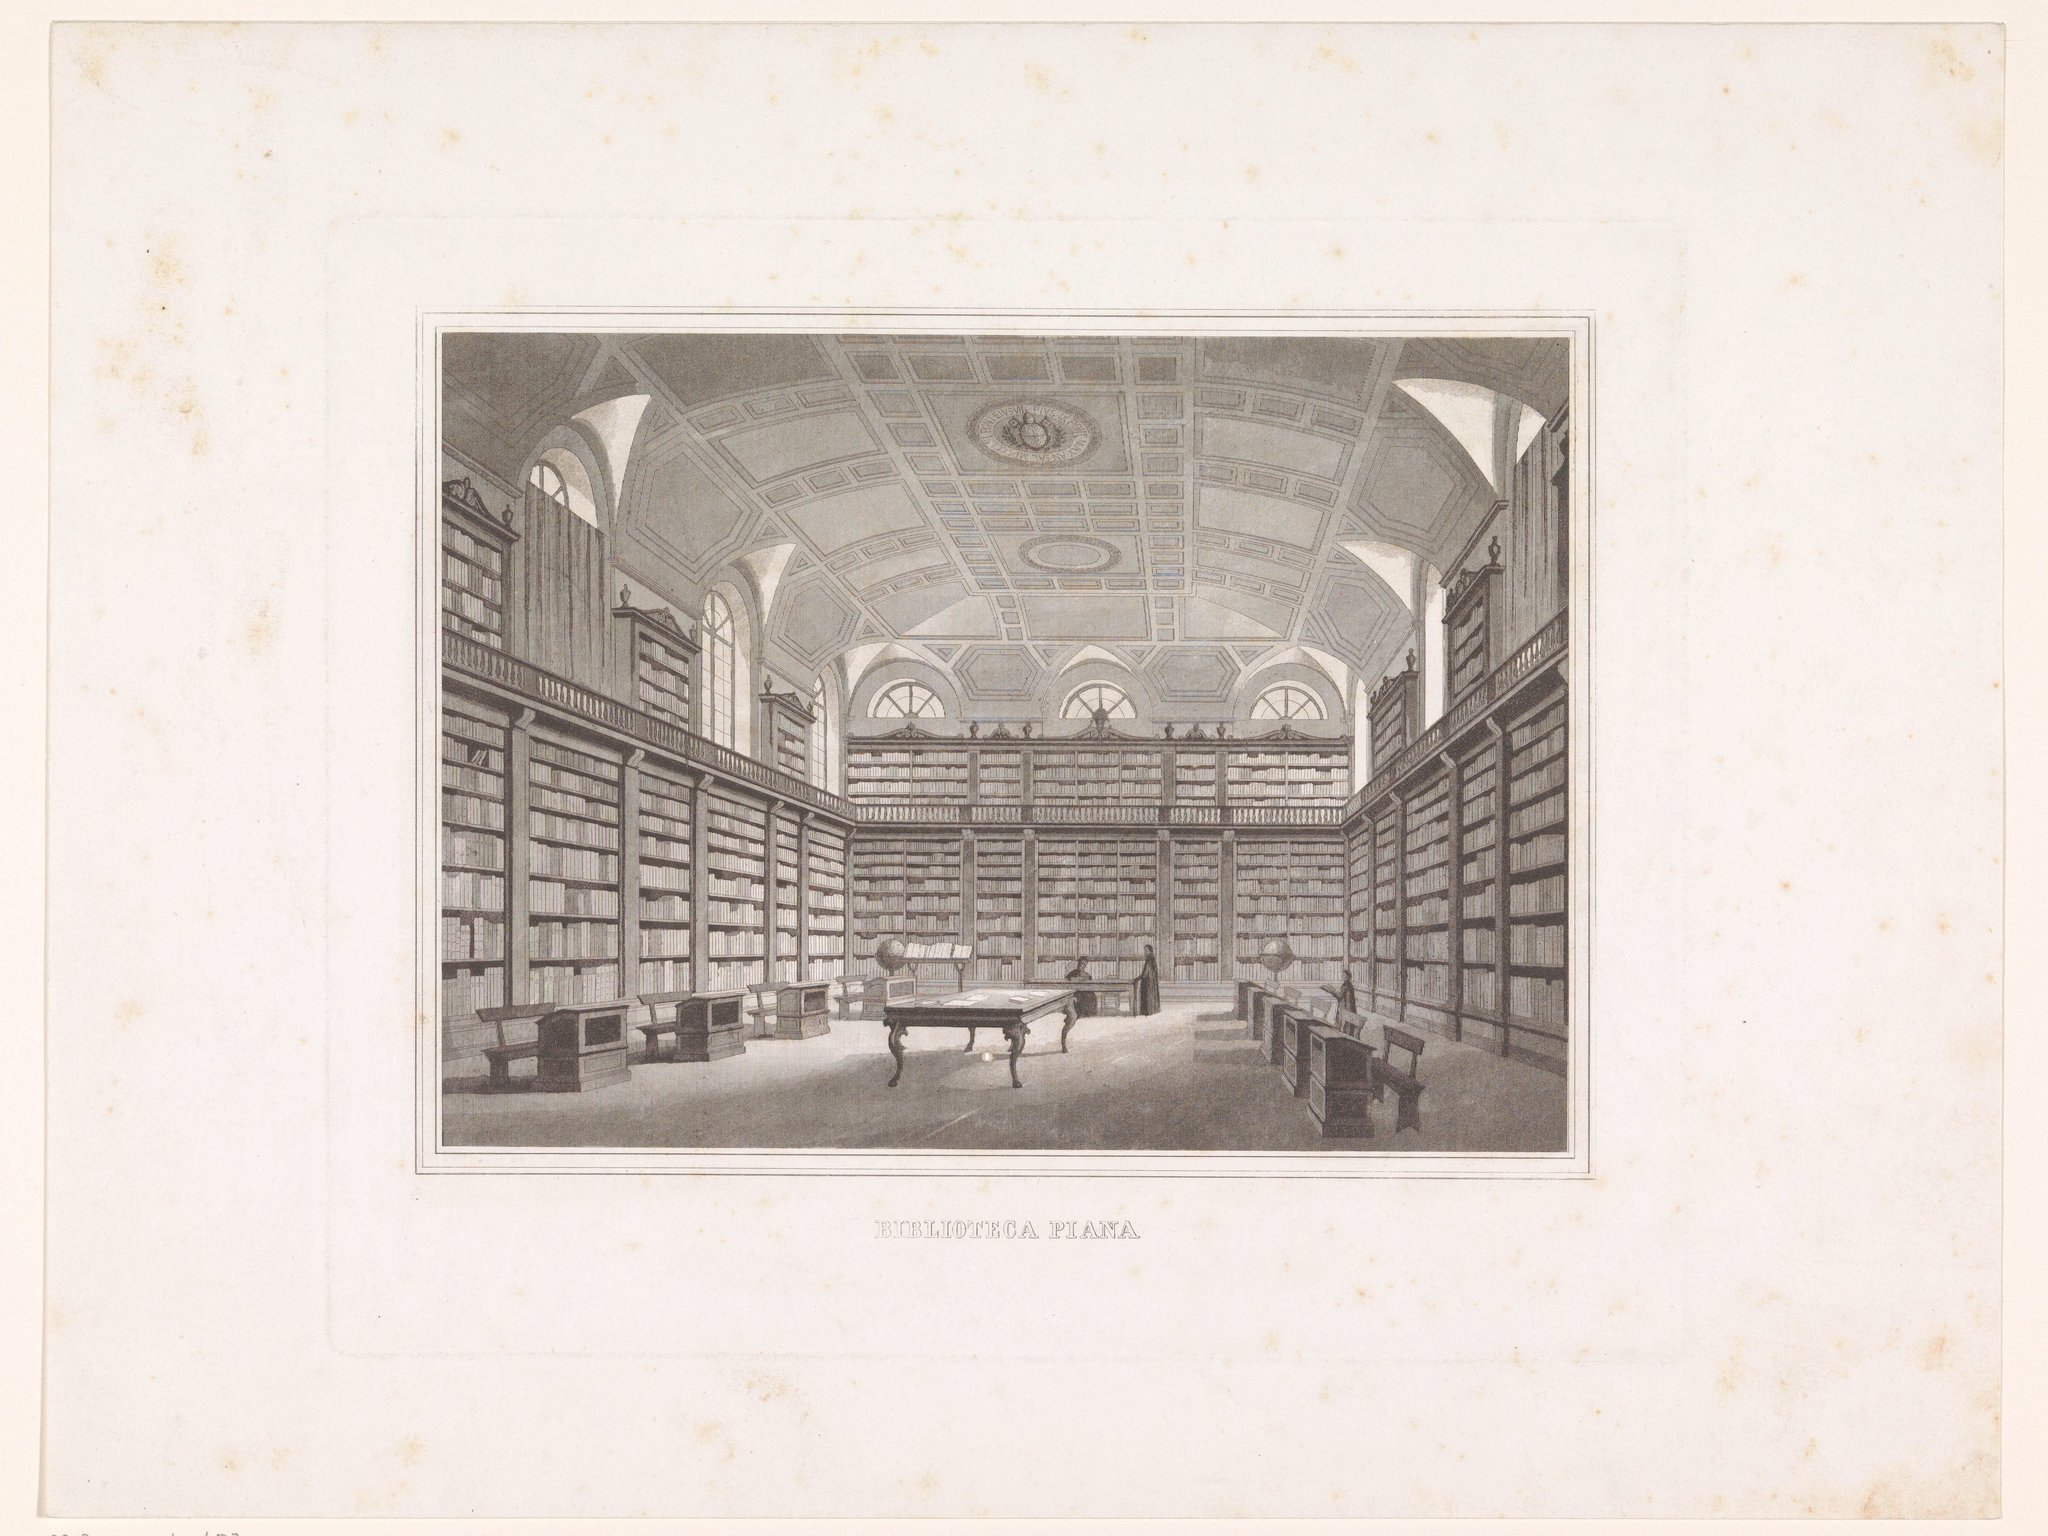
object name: print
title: Biblioteca Piana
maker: Anonymous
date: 1850-1900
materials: paper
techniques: aquatint, etching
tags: public library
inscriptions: collector's mark: Lugt 4779, collector's mark: Lugt 2228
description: Op het plafond het wapen van Paus Pius IX.